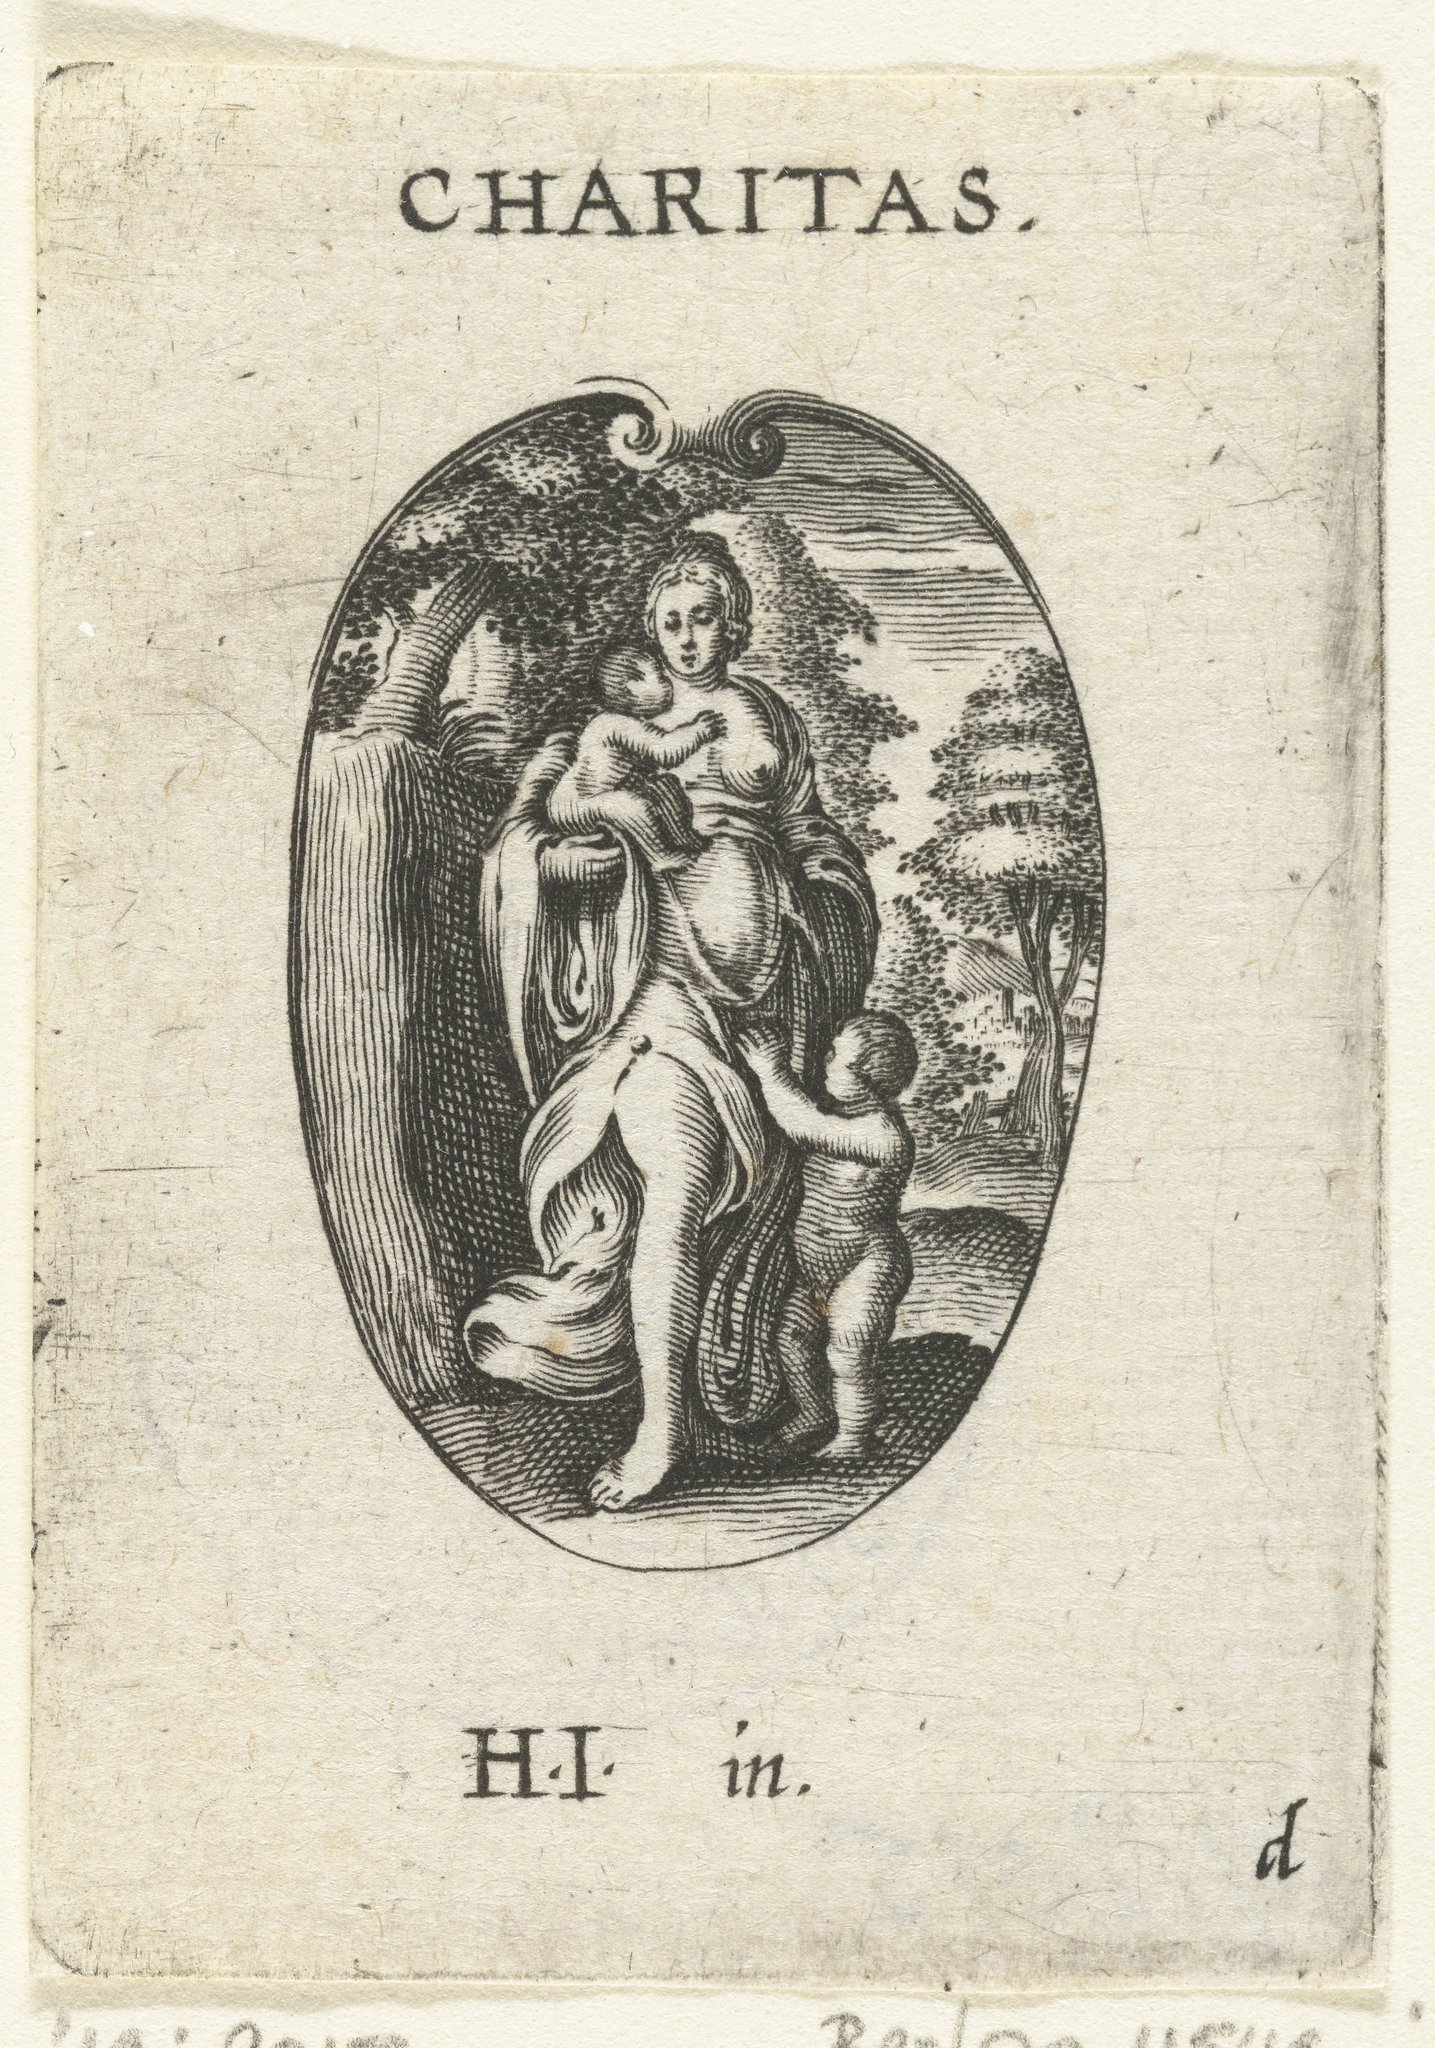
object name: ornament print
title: Kleine ovalen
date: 1600-1699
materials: paper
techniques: engraving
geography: amsterdam